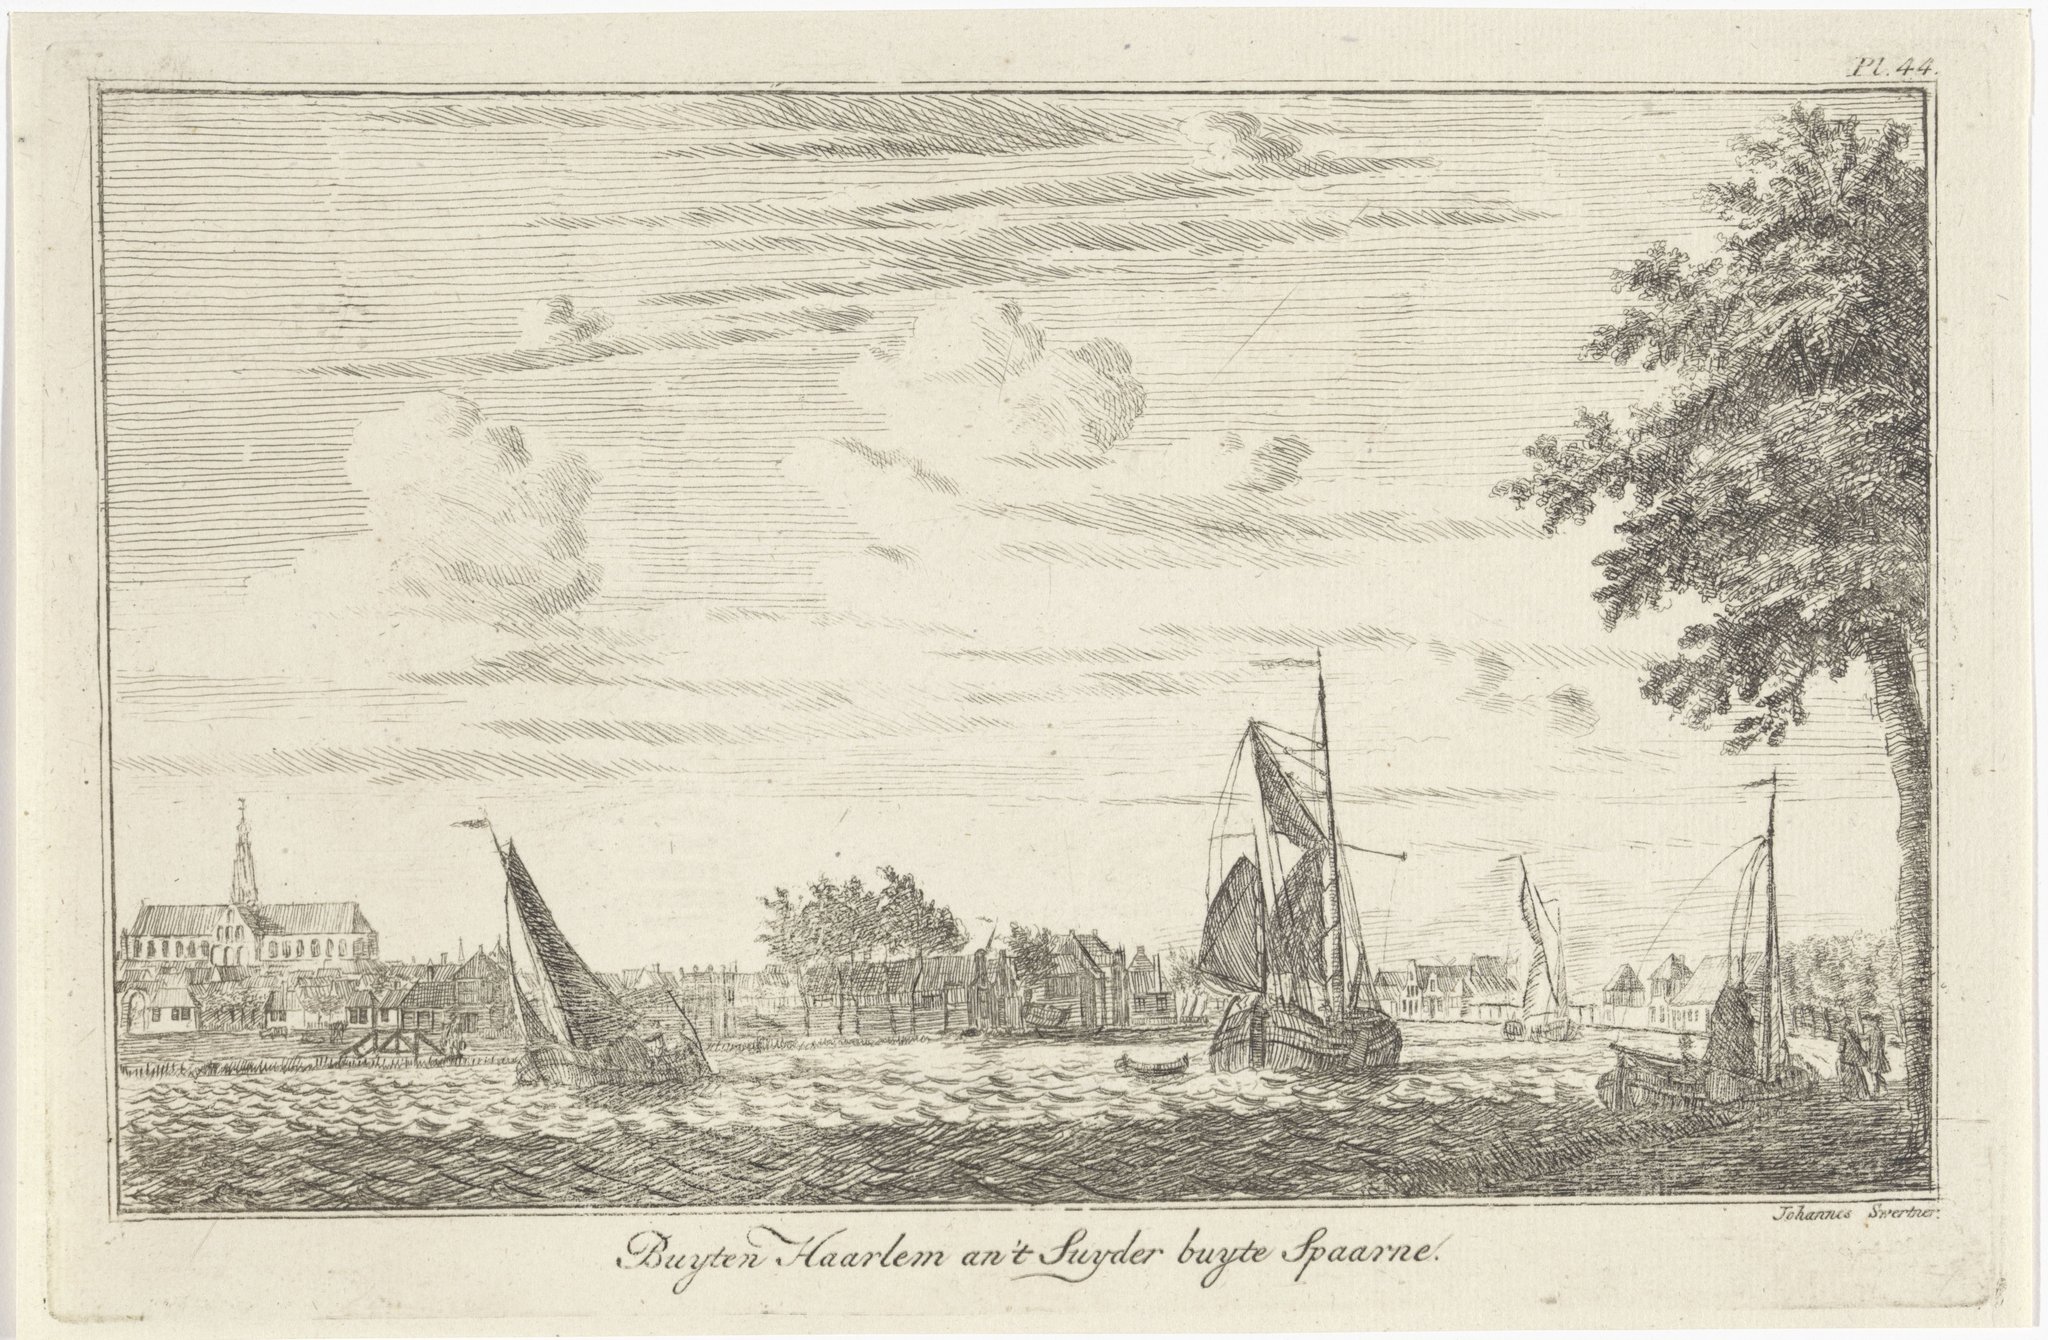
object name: print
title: Gezicht op Haarlem over het water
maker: johannes swertner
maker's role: draughtsman, painter, print maker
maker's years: 1746-1813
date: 1763-1813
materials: paper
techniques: etching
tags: haarlem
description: Gezicht op Haarlem over het water. Op het water verschillende zeilschepen, op de oever enkele wandelaars. Rechtsboven genummerd "Pl. 44".